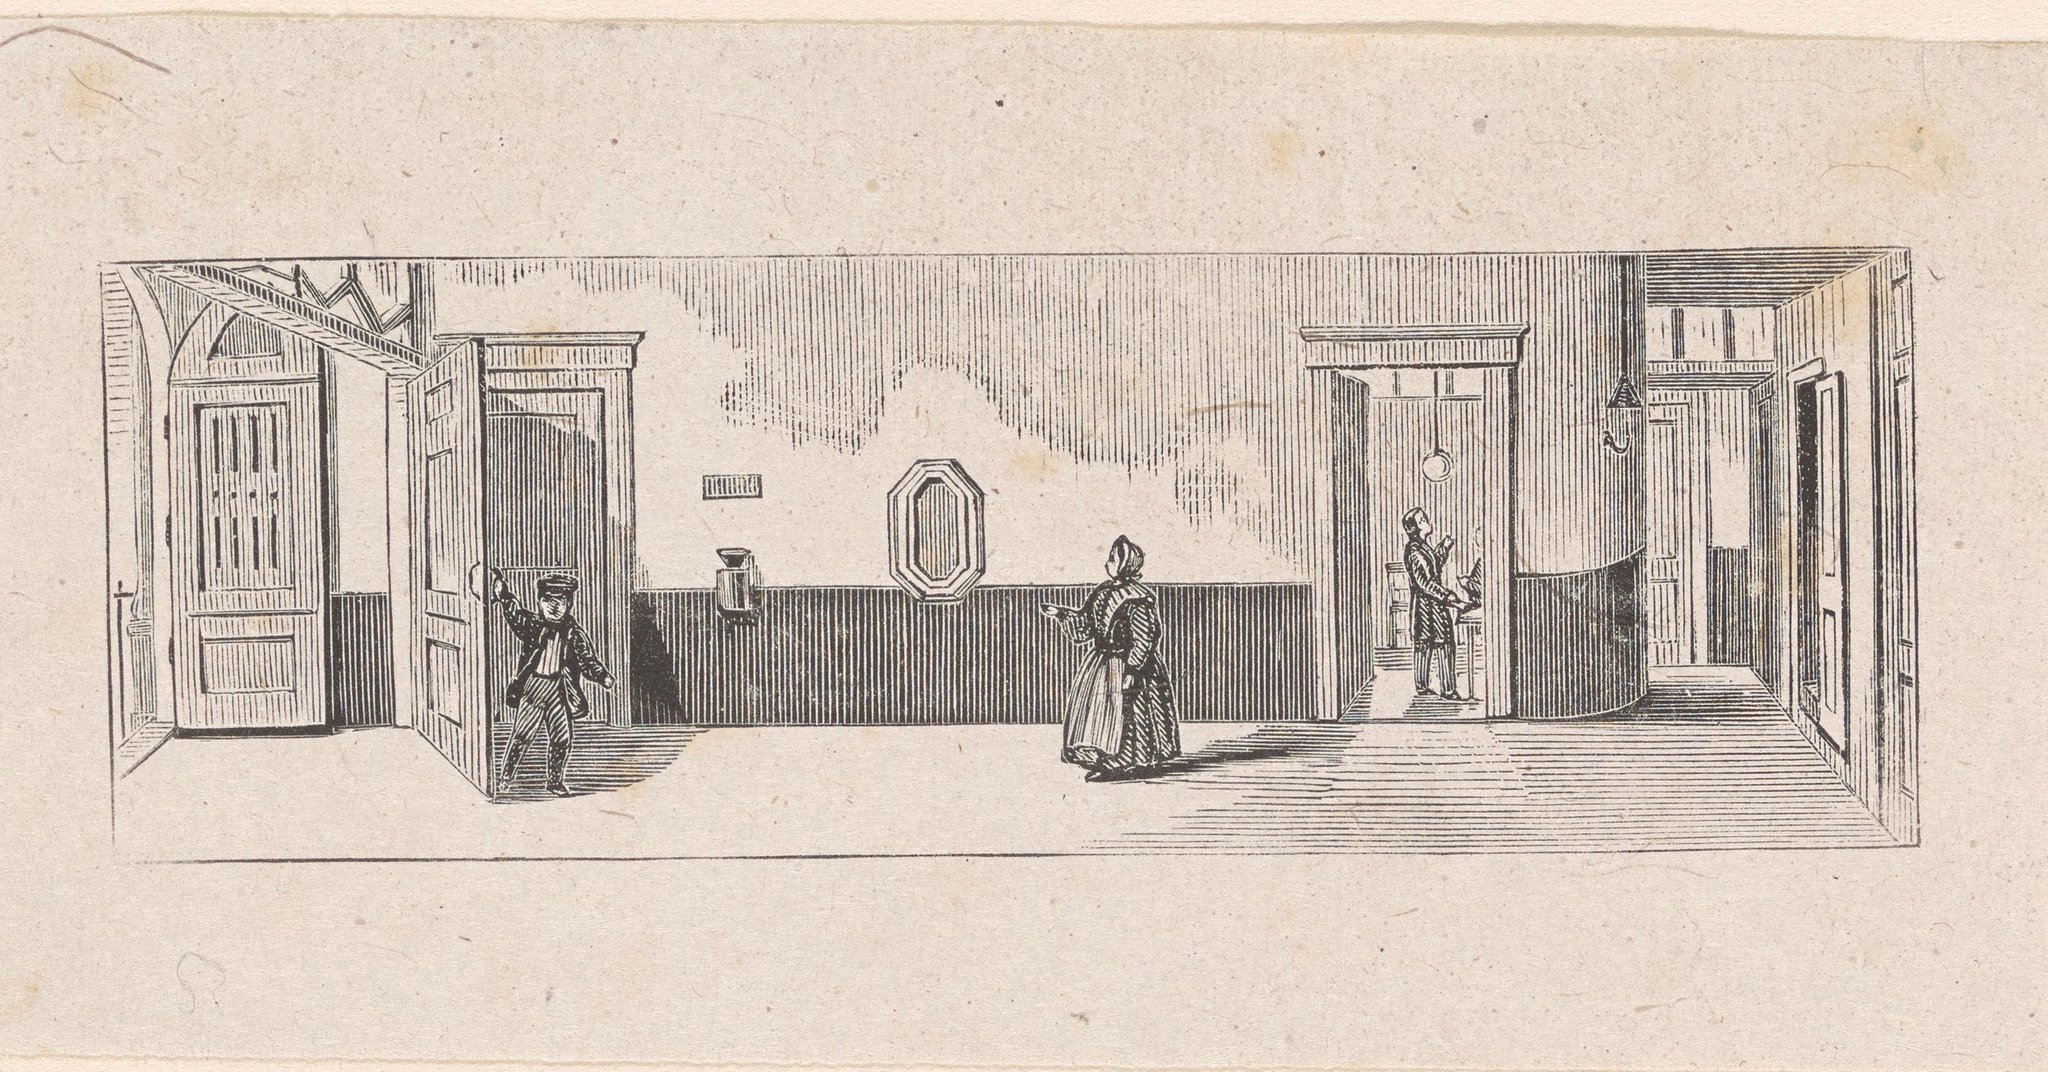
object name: print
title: Interieur met een jongen, een vrouw en een man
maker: isaac weissenbruch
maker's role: print maker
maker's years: 1826-1912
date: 1836-1912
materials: paper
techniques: engraving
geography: netherlands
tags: child, adult woman (+ standing), adult man (+ standing)